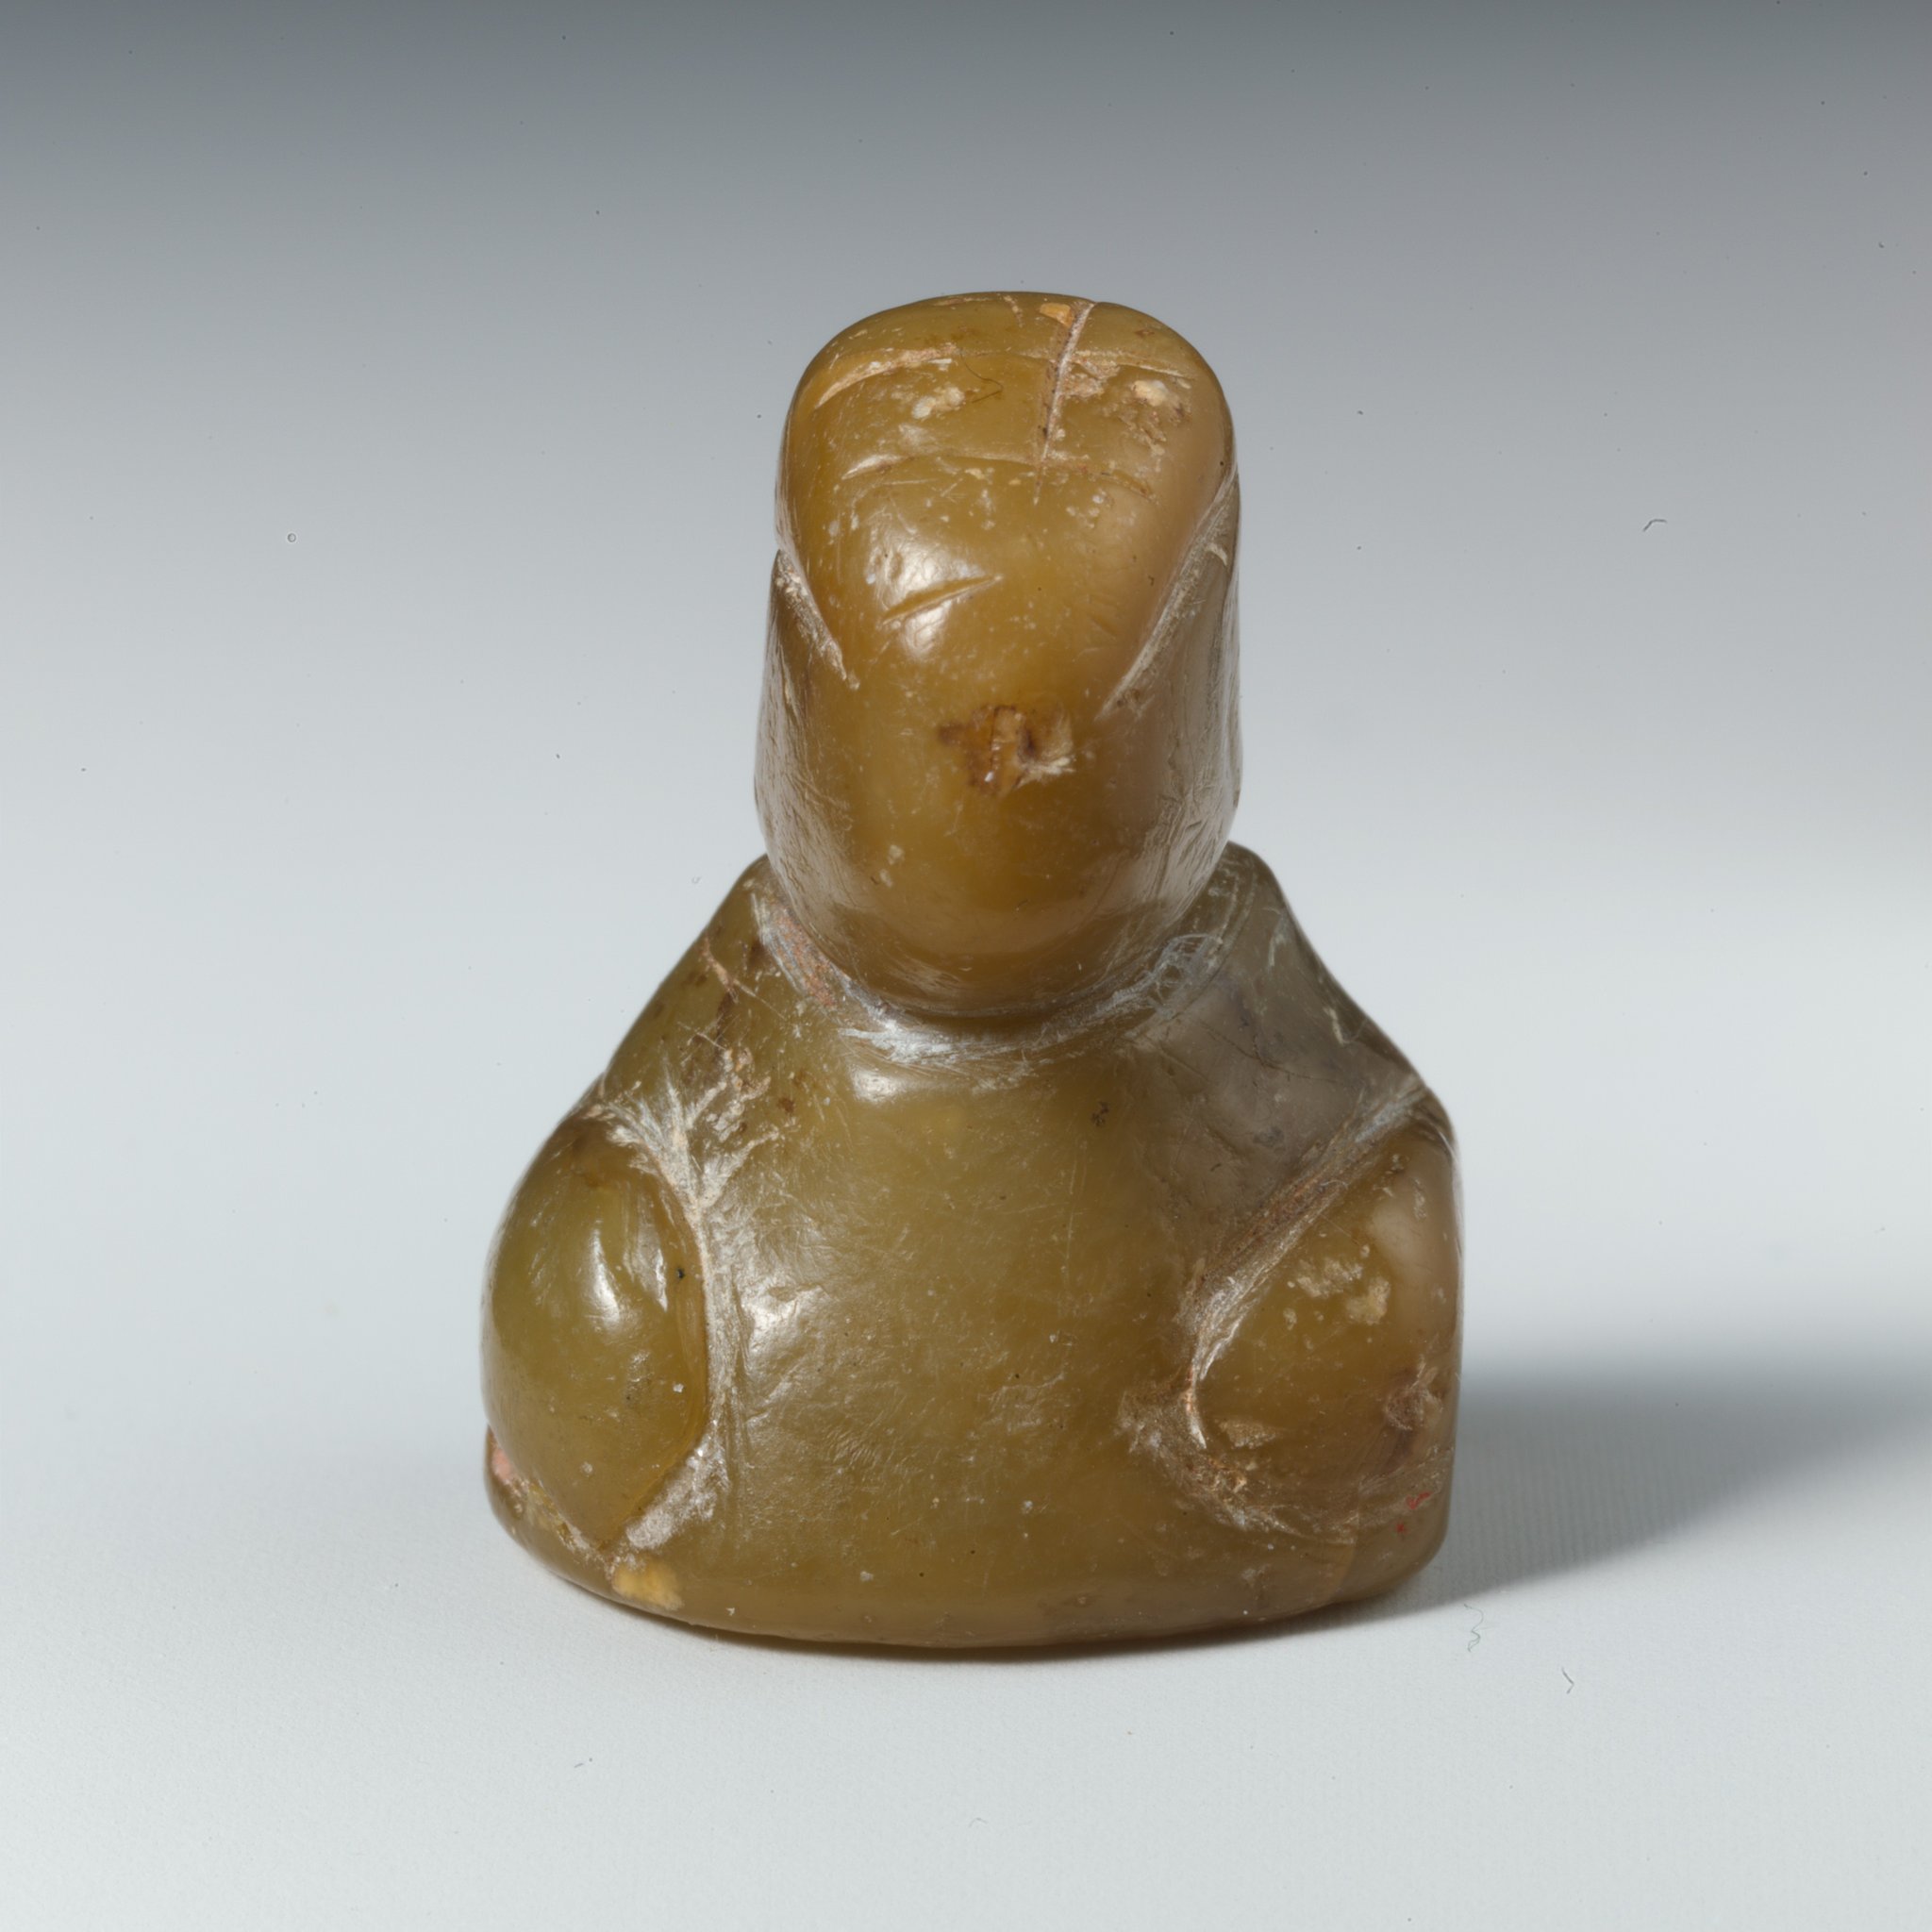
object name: portrait bust, girl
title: Steatite bust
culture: minoan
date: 3000-1600 BCE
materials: stone